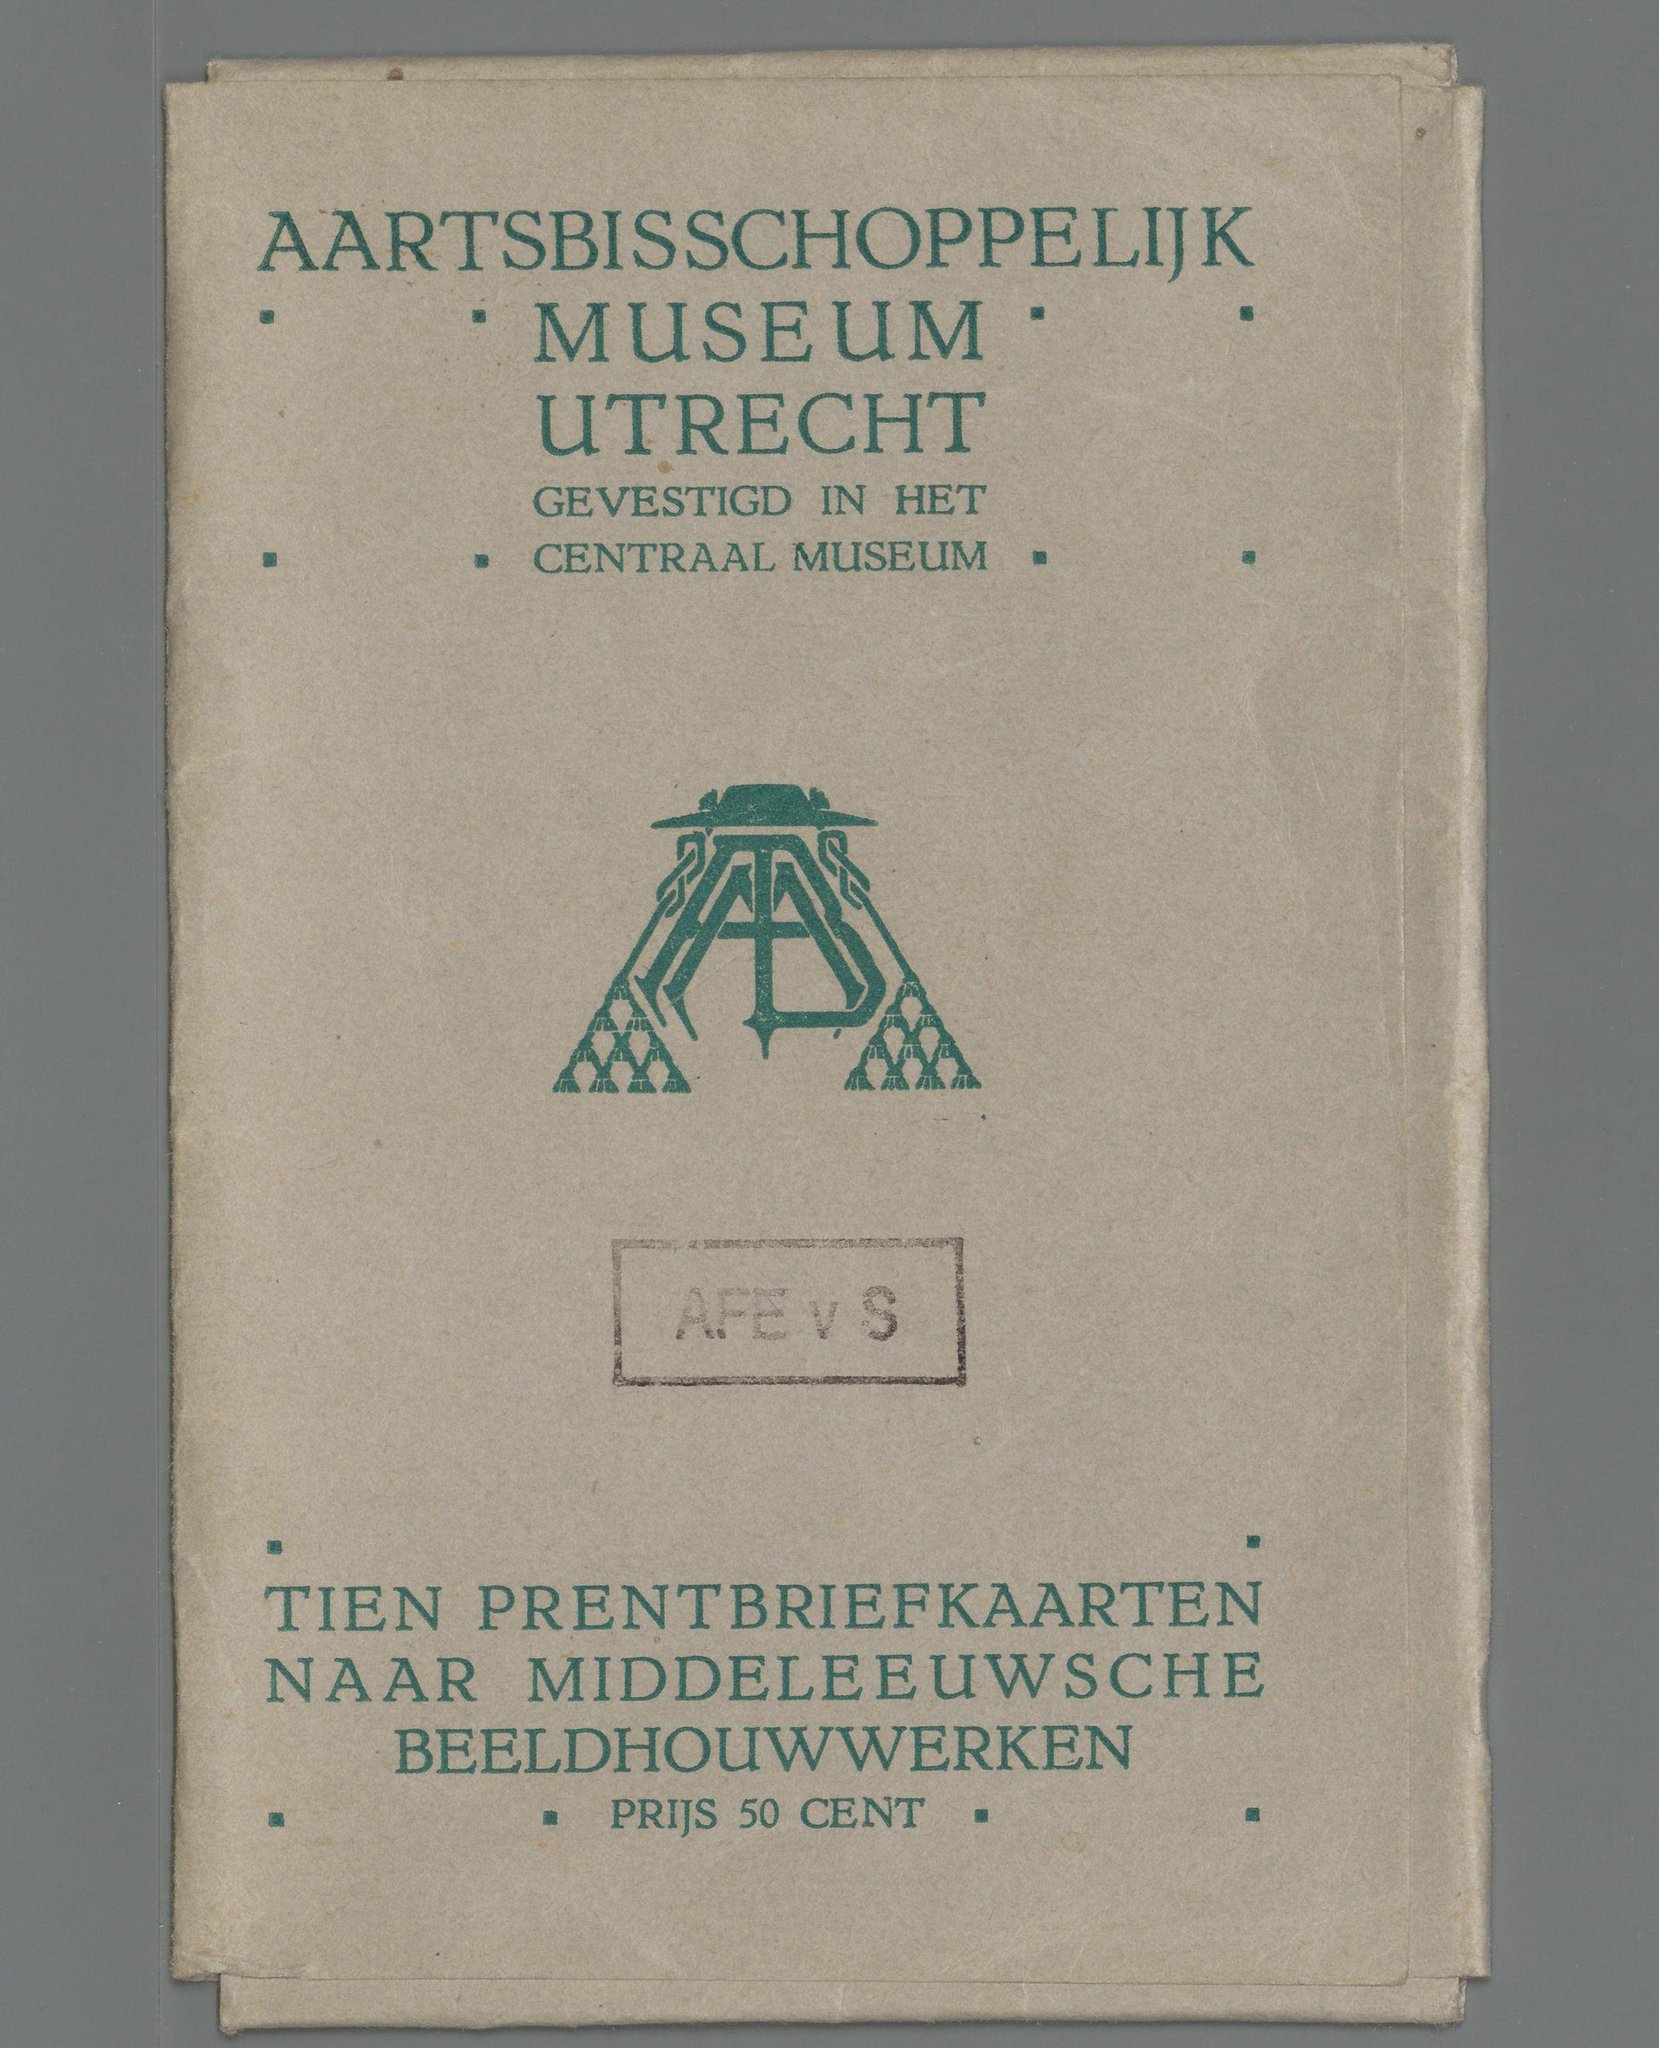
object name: wrapper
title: Tien prentbriefkaarten naar Middeleeuwsche Beeldhouwwerken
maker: Anonymous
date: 1921-1940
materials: cardboard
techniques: letterpress printing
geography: utrecht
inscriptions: collector's mark: ‘AFE v S’